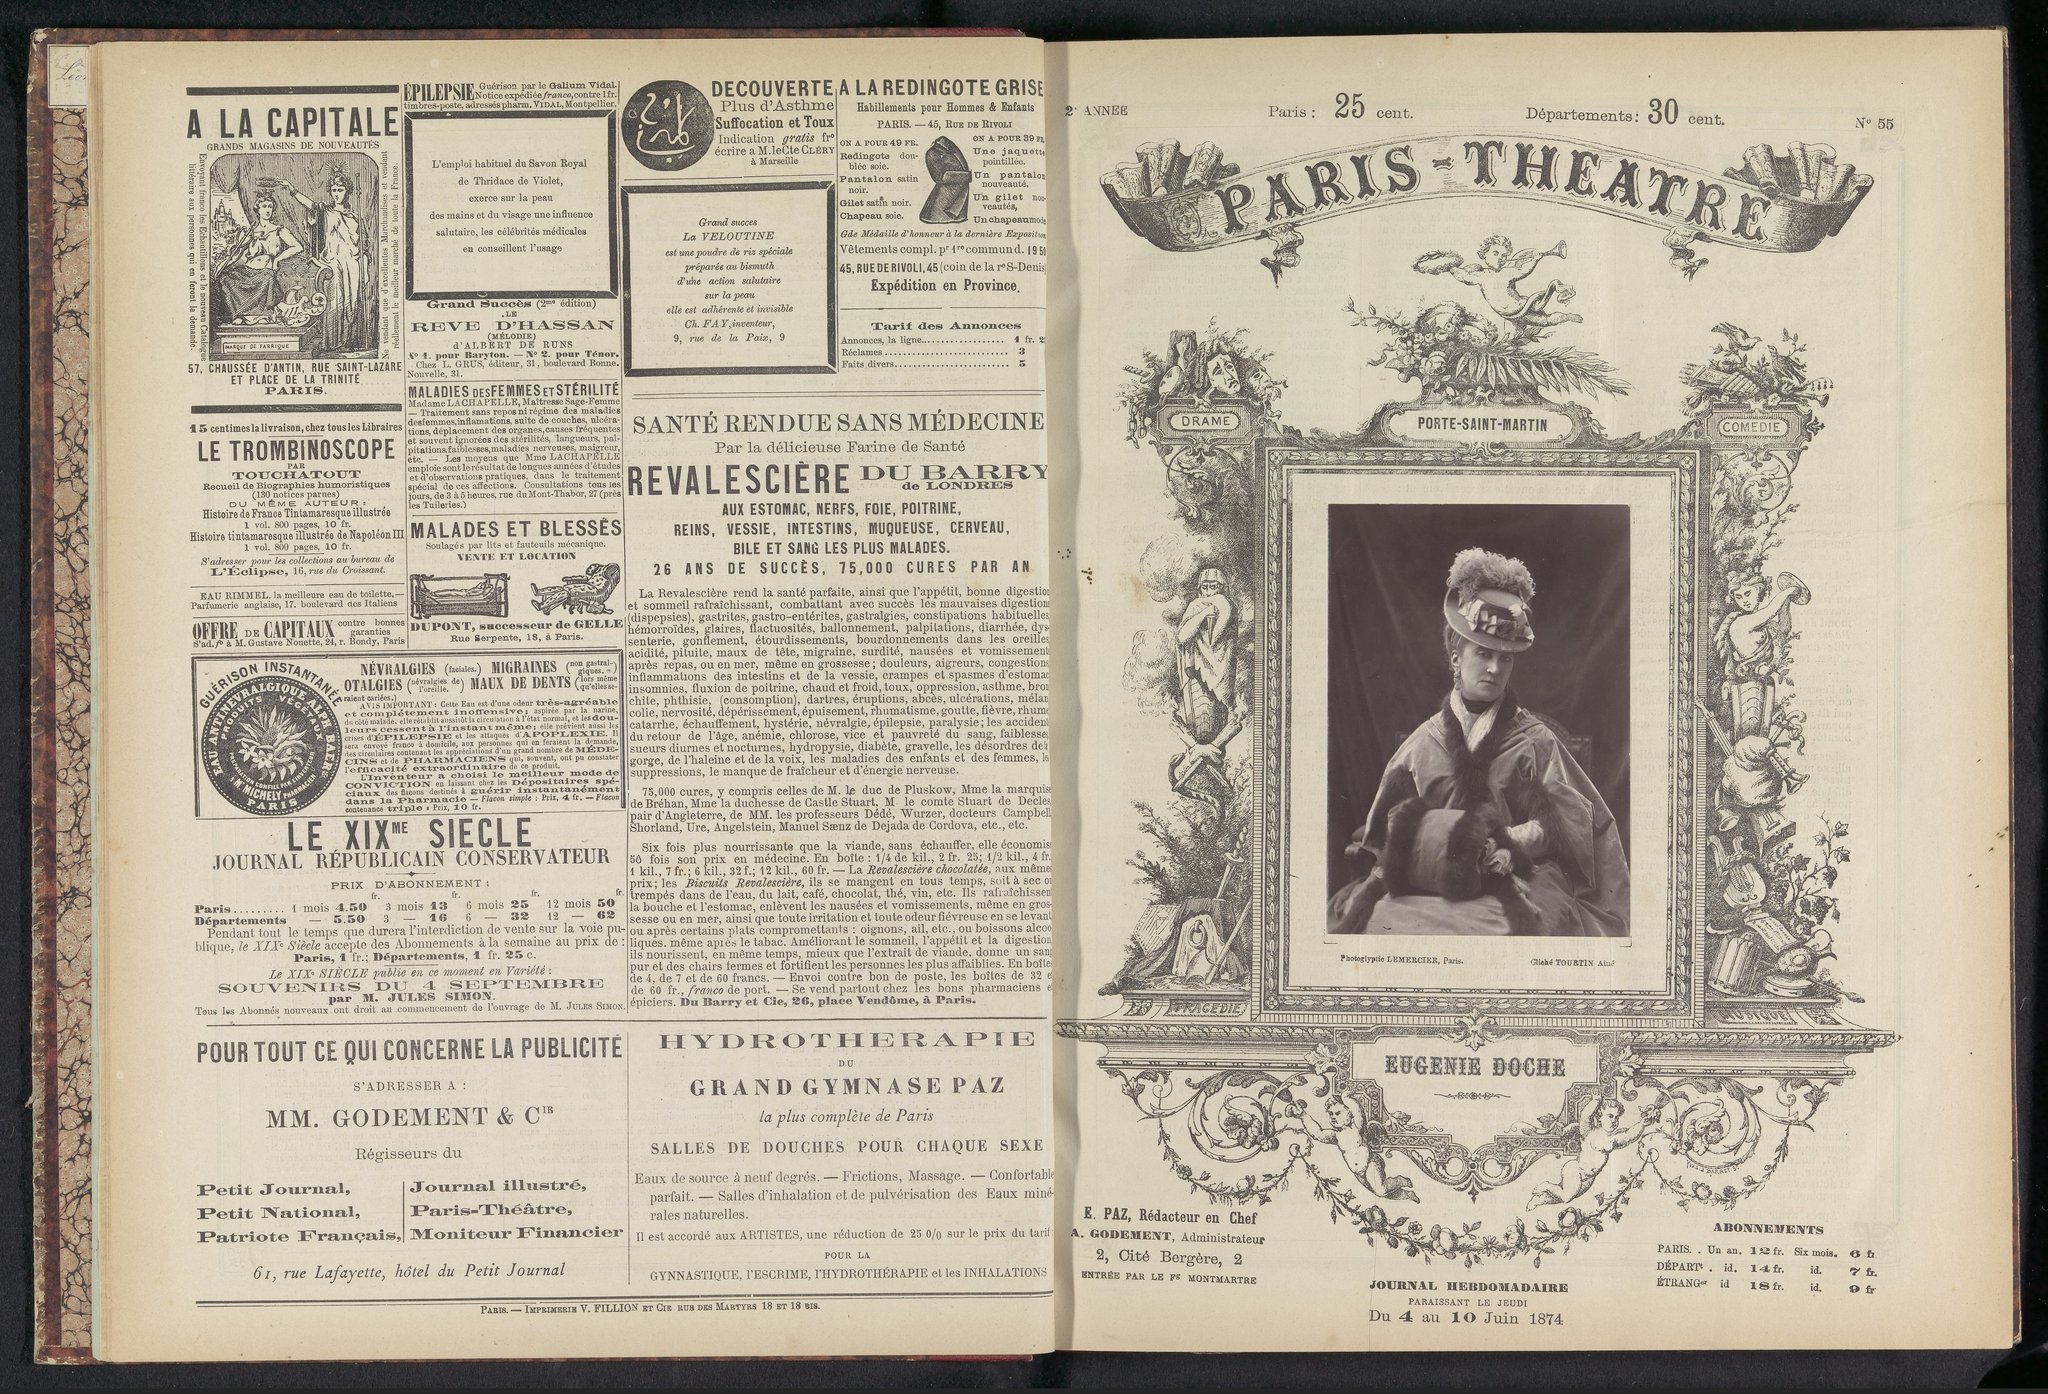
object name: page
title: Portret van Eugénie Doche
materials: paper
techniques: woodburytype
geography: france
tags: portrait of actor, actress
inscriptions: number: ‘No 55’, inscription: ‘Journal hebdomadaire paraissant le jeudi Du 4 au 10 Juin 1874.’